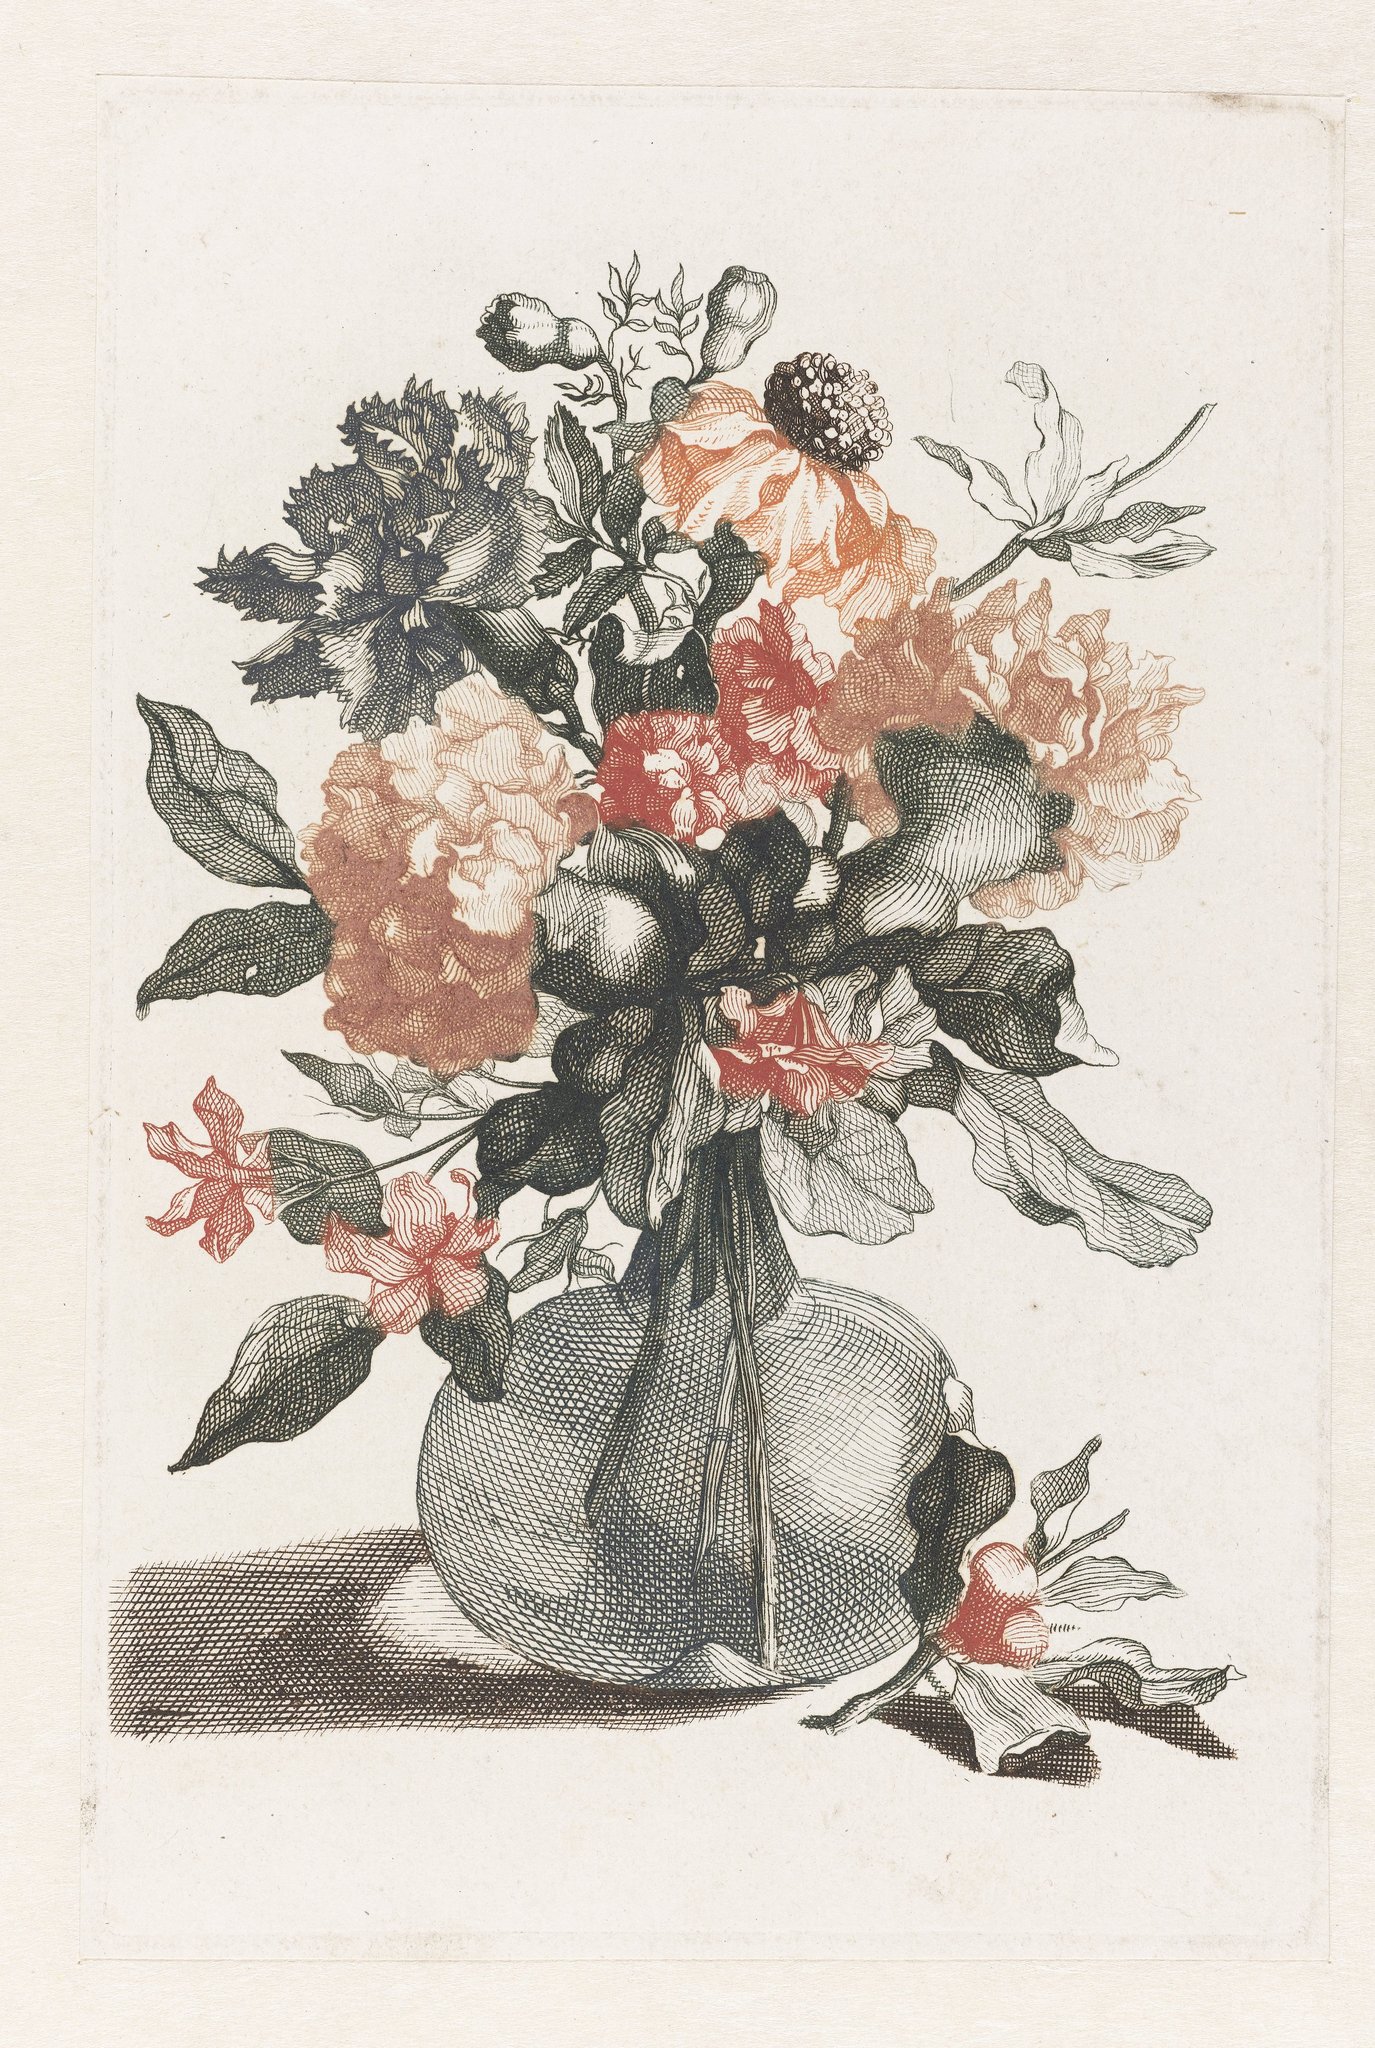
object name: print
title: Glazen vaas met bloemen en voor de vaas een tak met bloem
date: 1688-1698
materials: paper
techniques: engraving, etching, lithography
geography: netherlands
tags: flowers in a vase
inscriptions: collector's mark: Lugt 2228